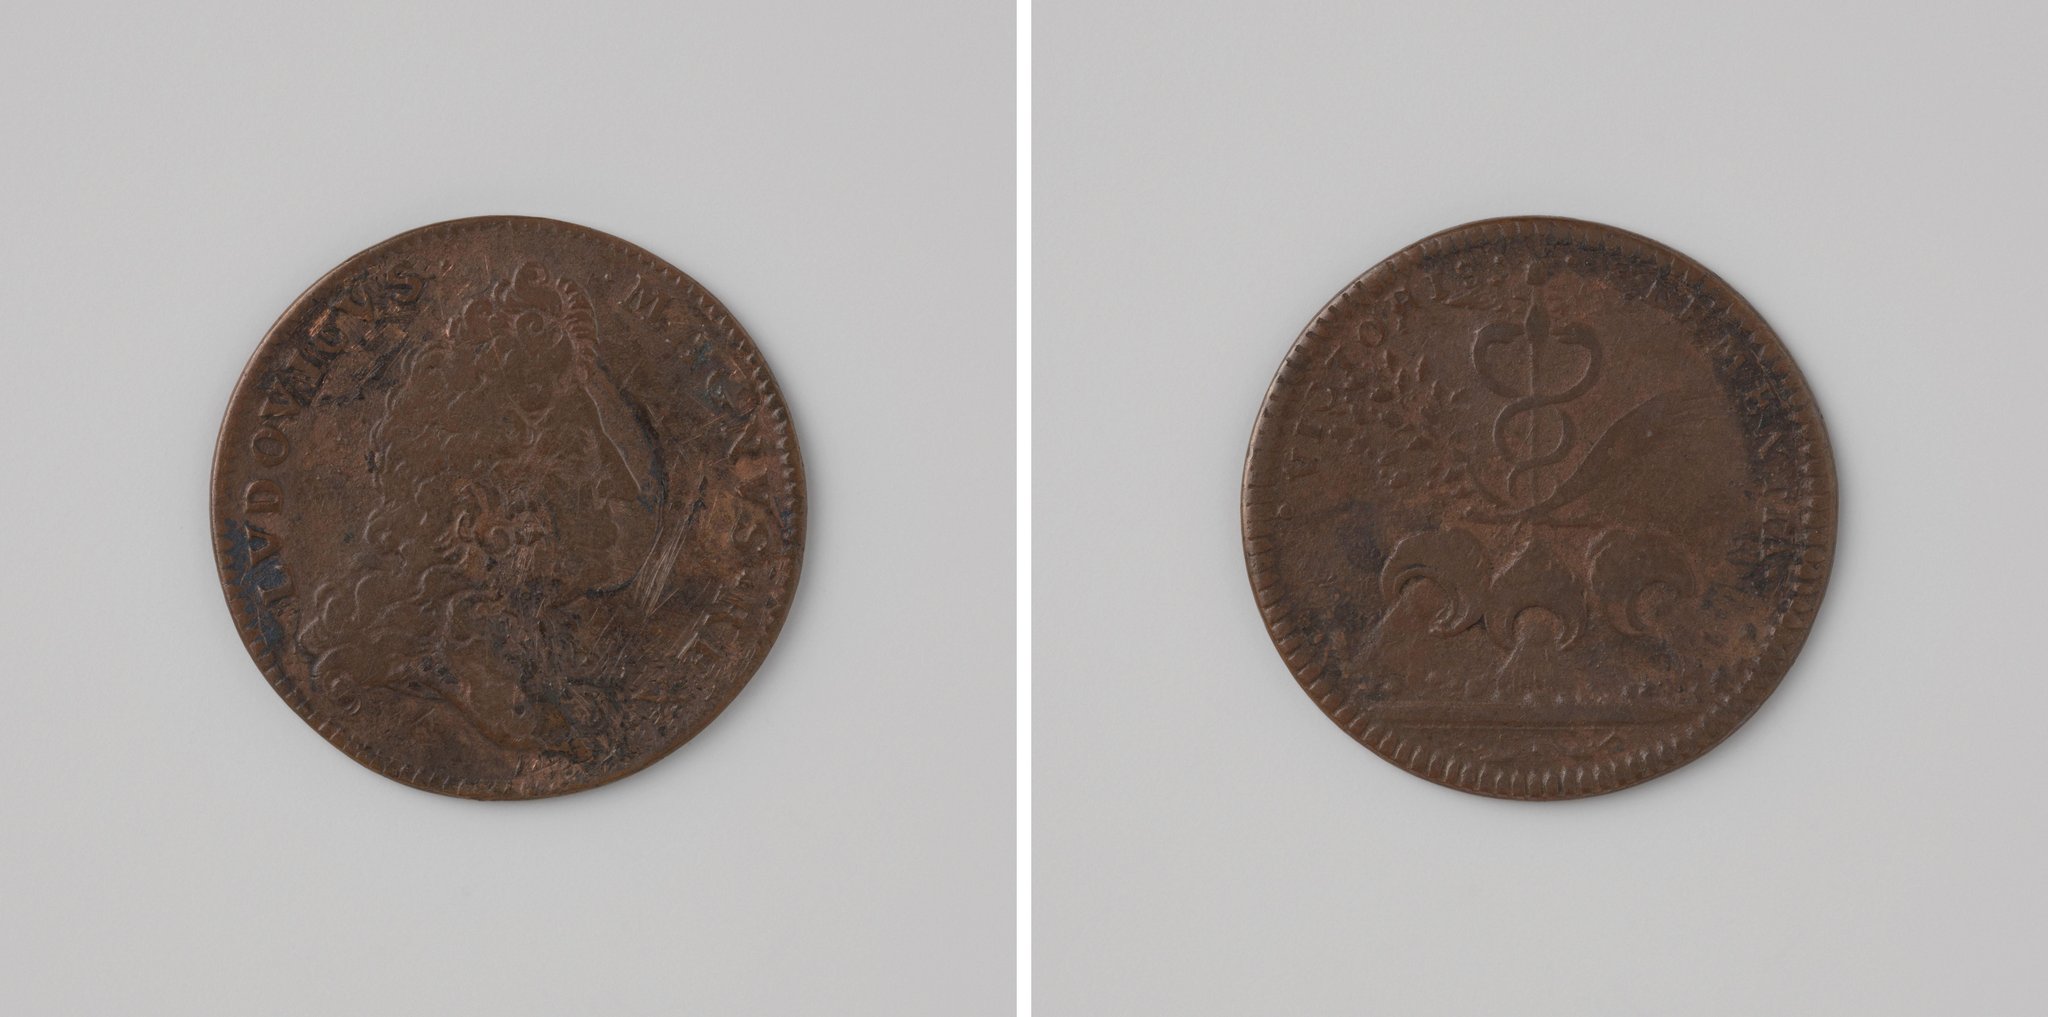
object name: jeton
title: Inname van Conde door Lodewijk XIV, koning van Frankrijk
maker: Anonymous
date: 1676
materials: copper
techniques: striking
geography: paris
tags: lodewijk xiv (koning van frankrijk)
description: Koperen penning. Voorzijde: borststuk man binnen omschrift. Keerzijde: drie waterkruiken voorstellende de rivieren Schelde, Aisne en Haisne met daartussen Mercuriusstaf met palm- en lauwertak binnen omschrift; afsnede: ornament